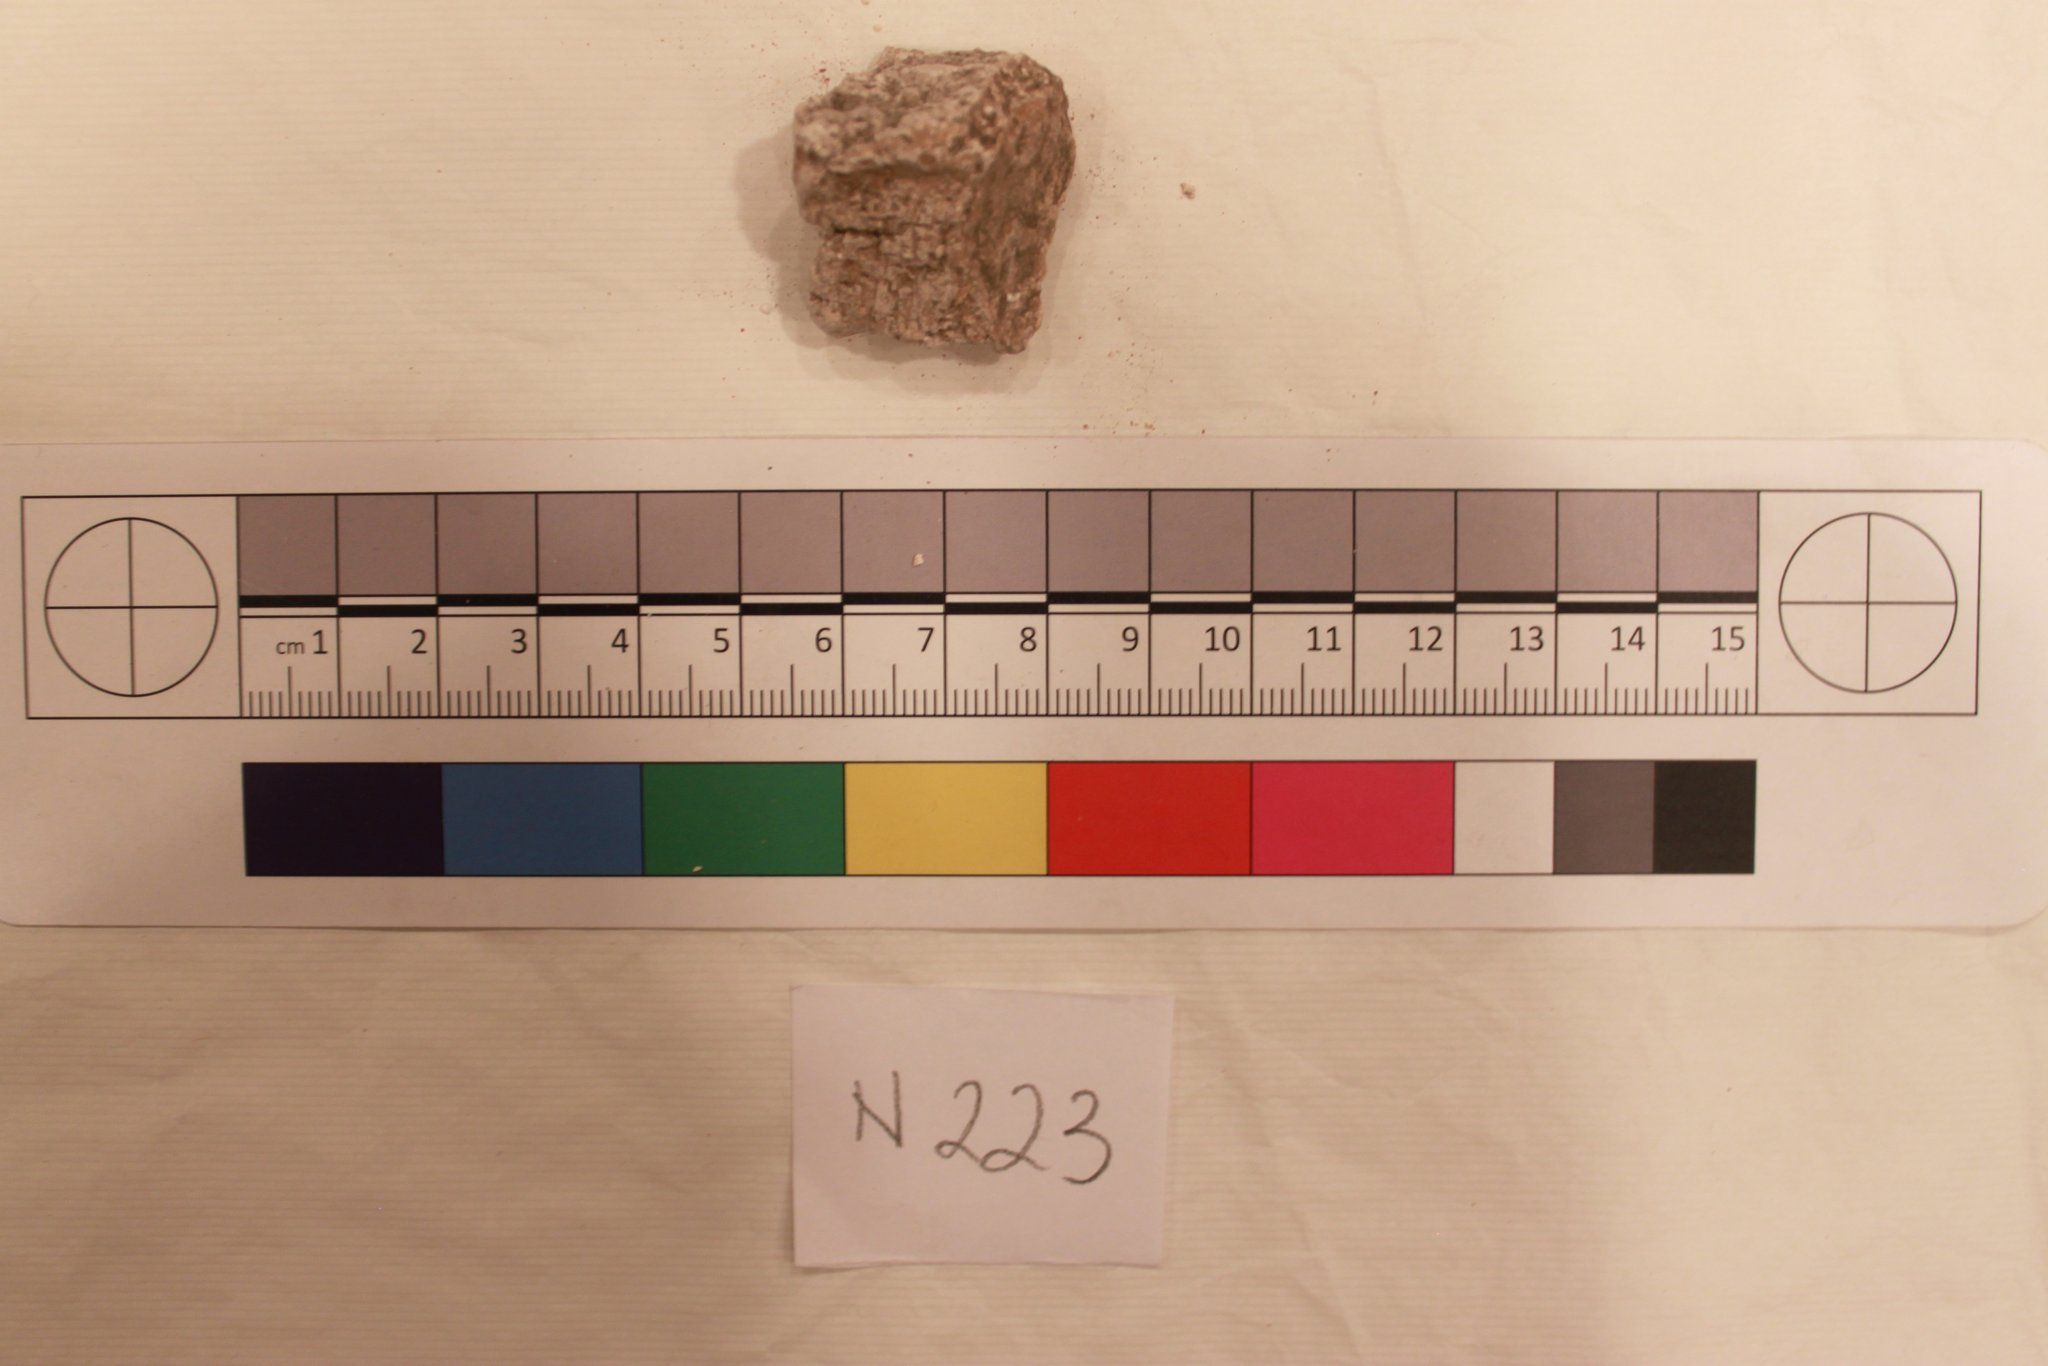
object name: fragment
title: Stucco Fragment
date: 701-1200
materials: plaster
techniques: carving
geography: iran